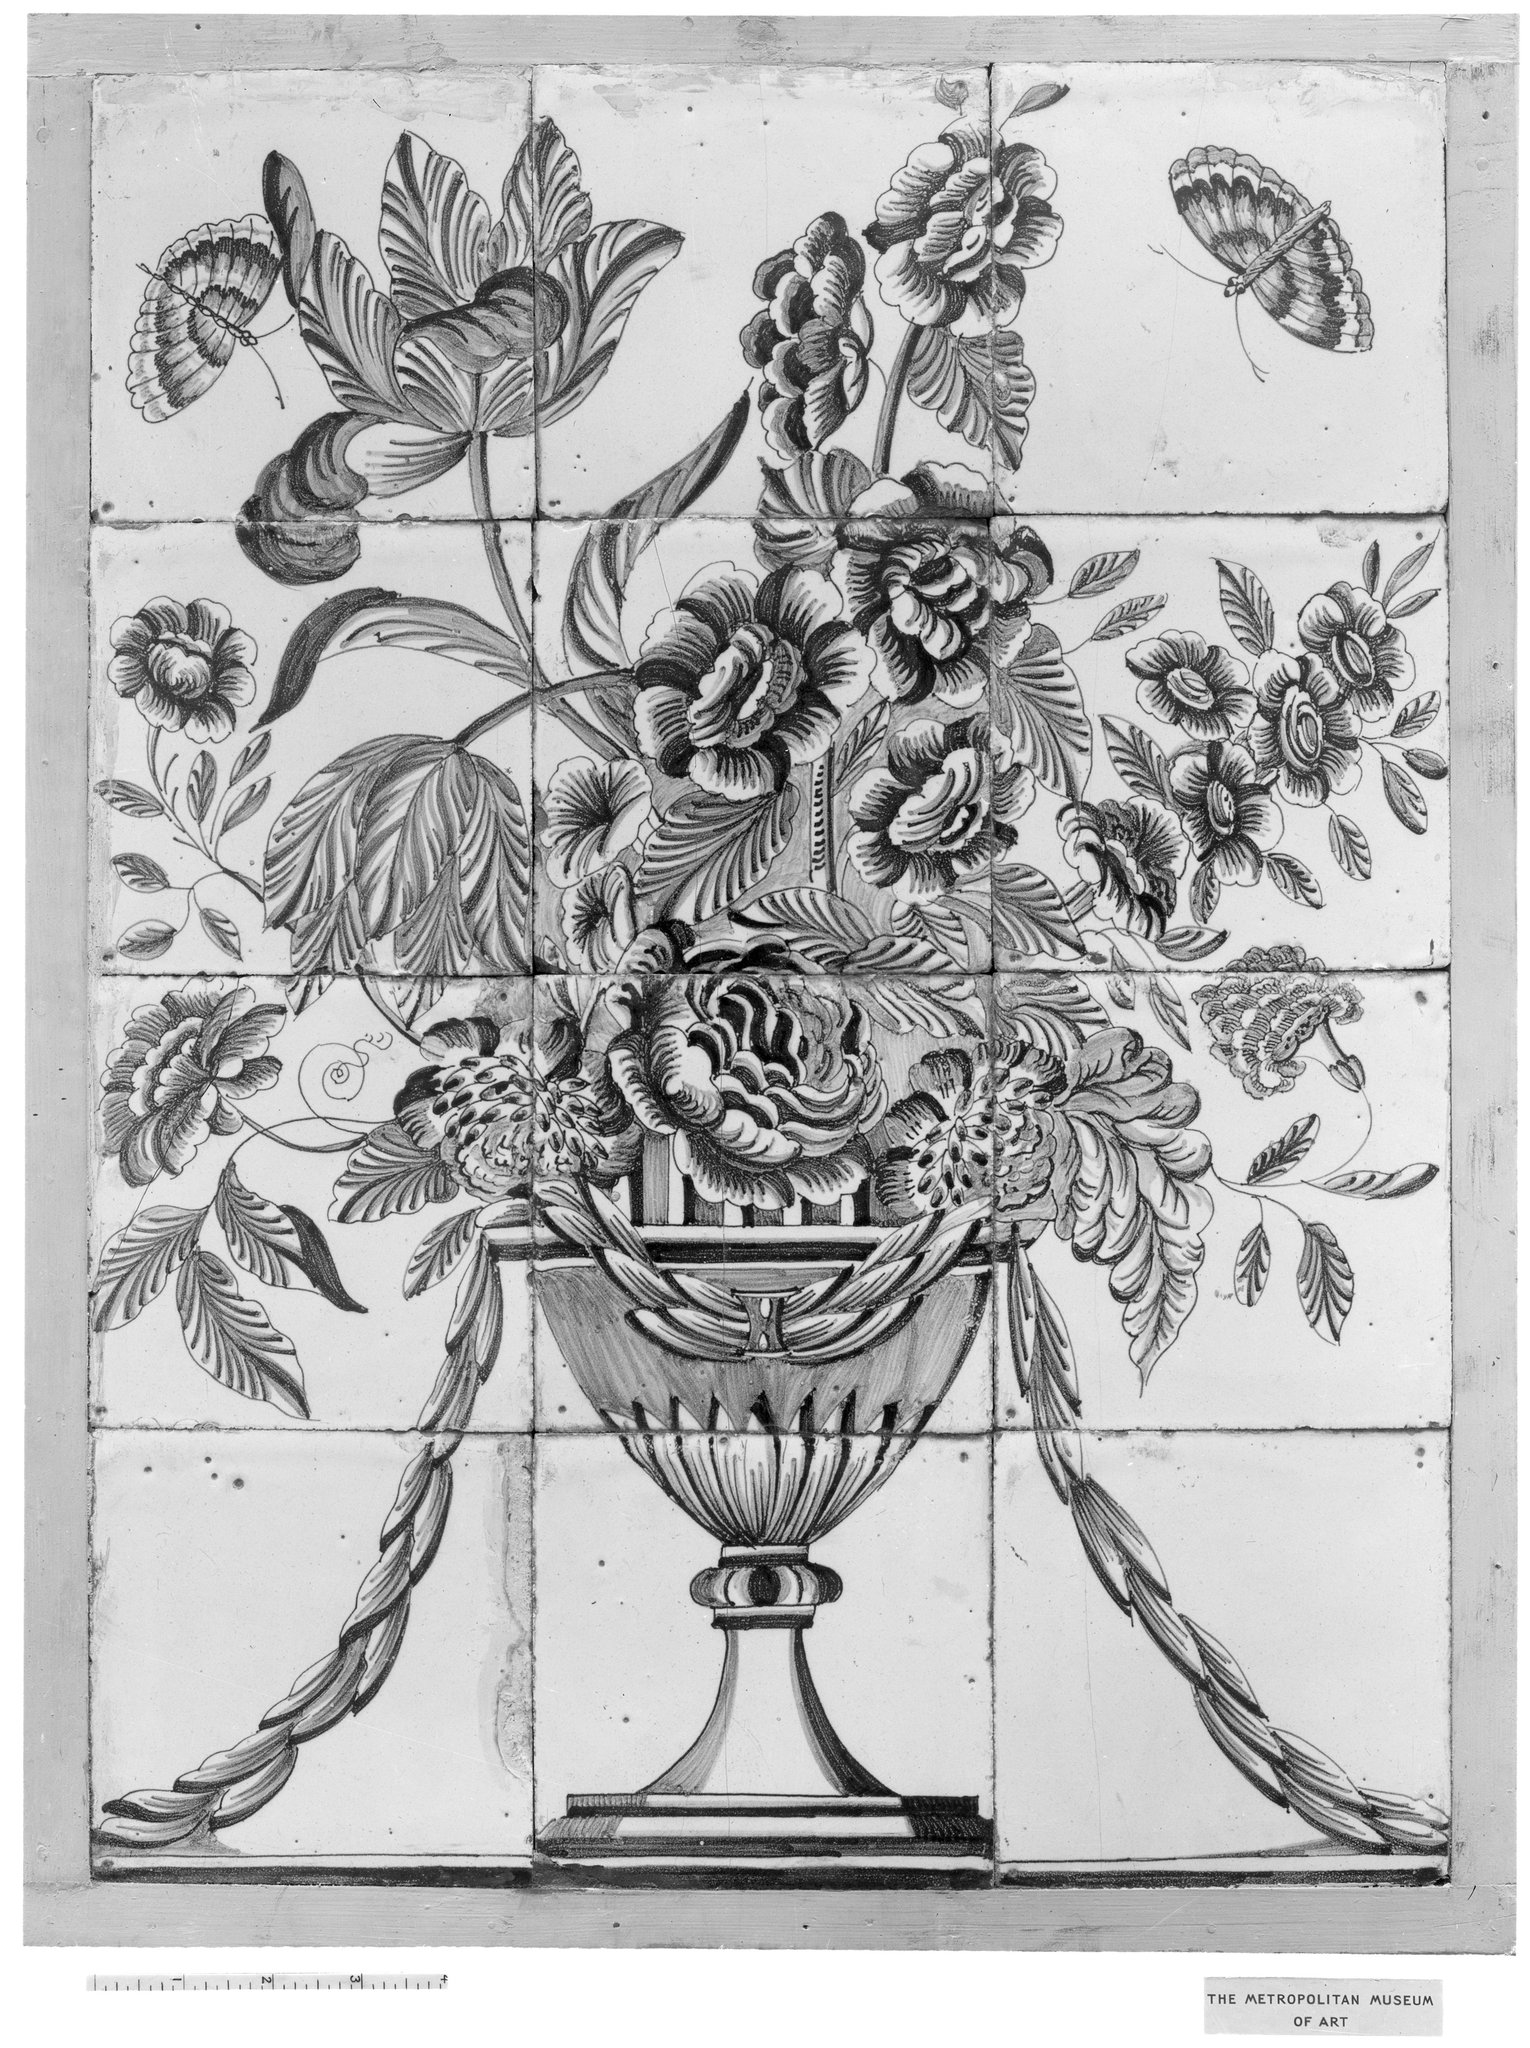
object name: tile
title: Panel of tiles (12)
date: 1767-1800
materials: earthenware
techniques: glazing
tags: butterflies,flowers